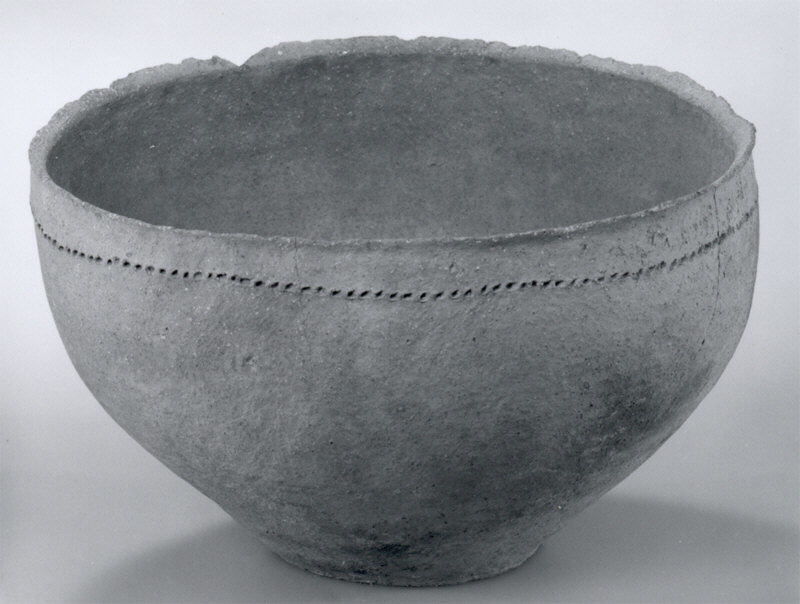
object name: bowl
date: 3500-3300 BCE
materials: ceramic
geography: levant